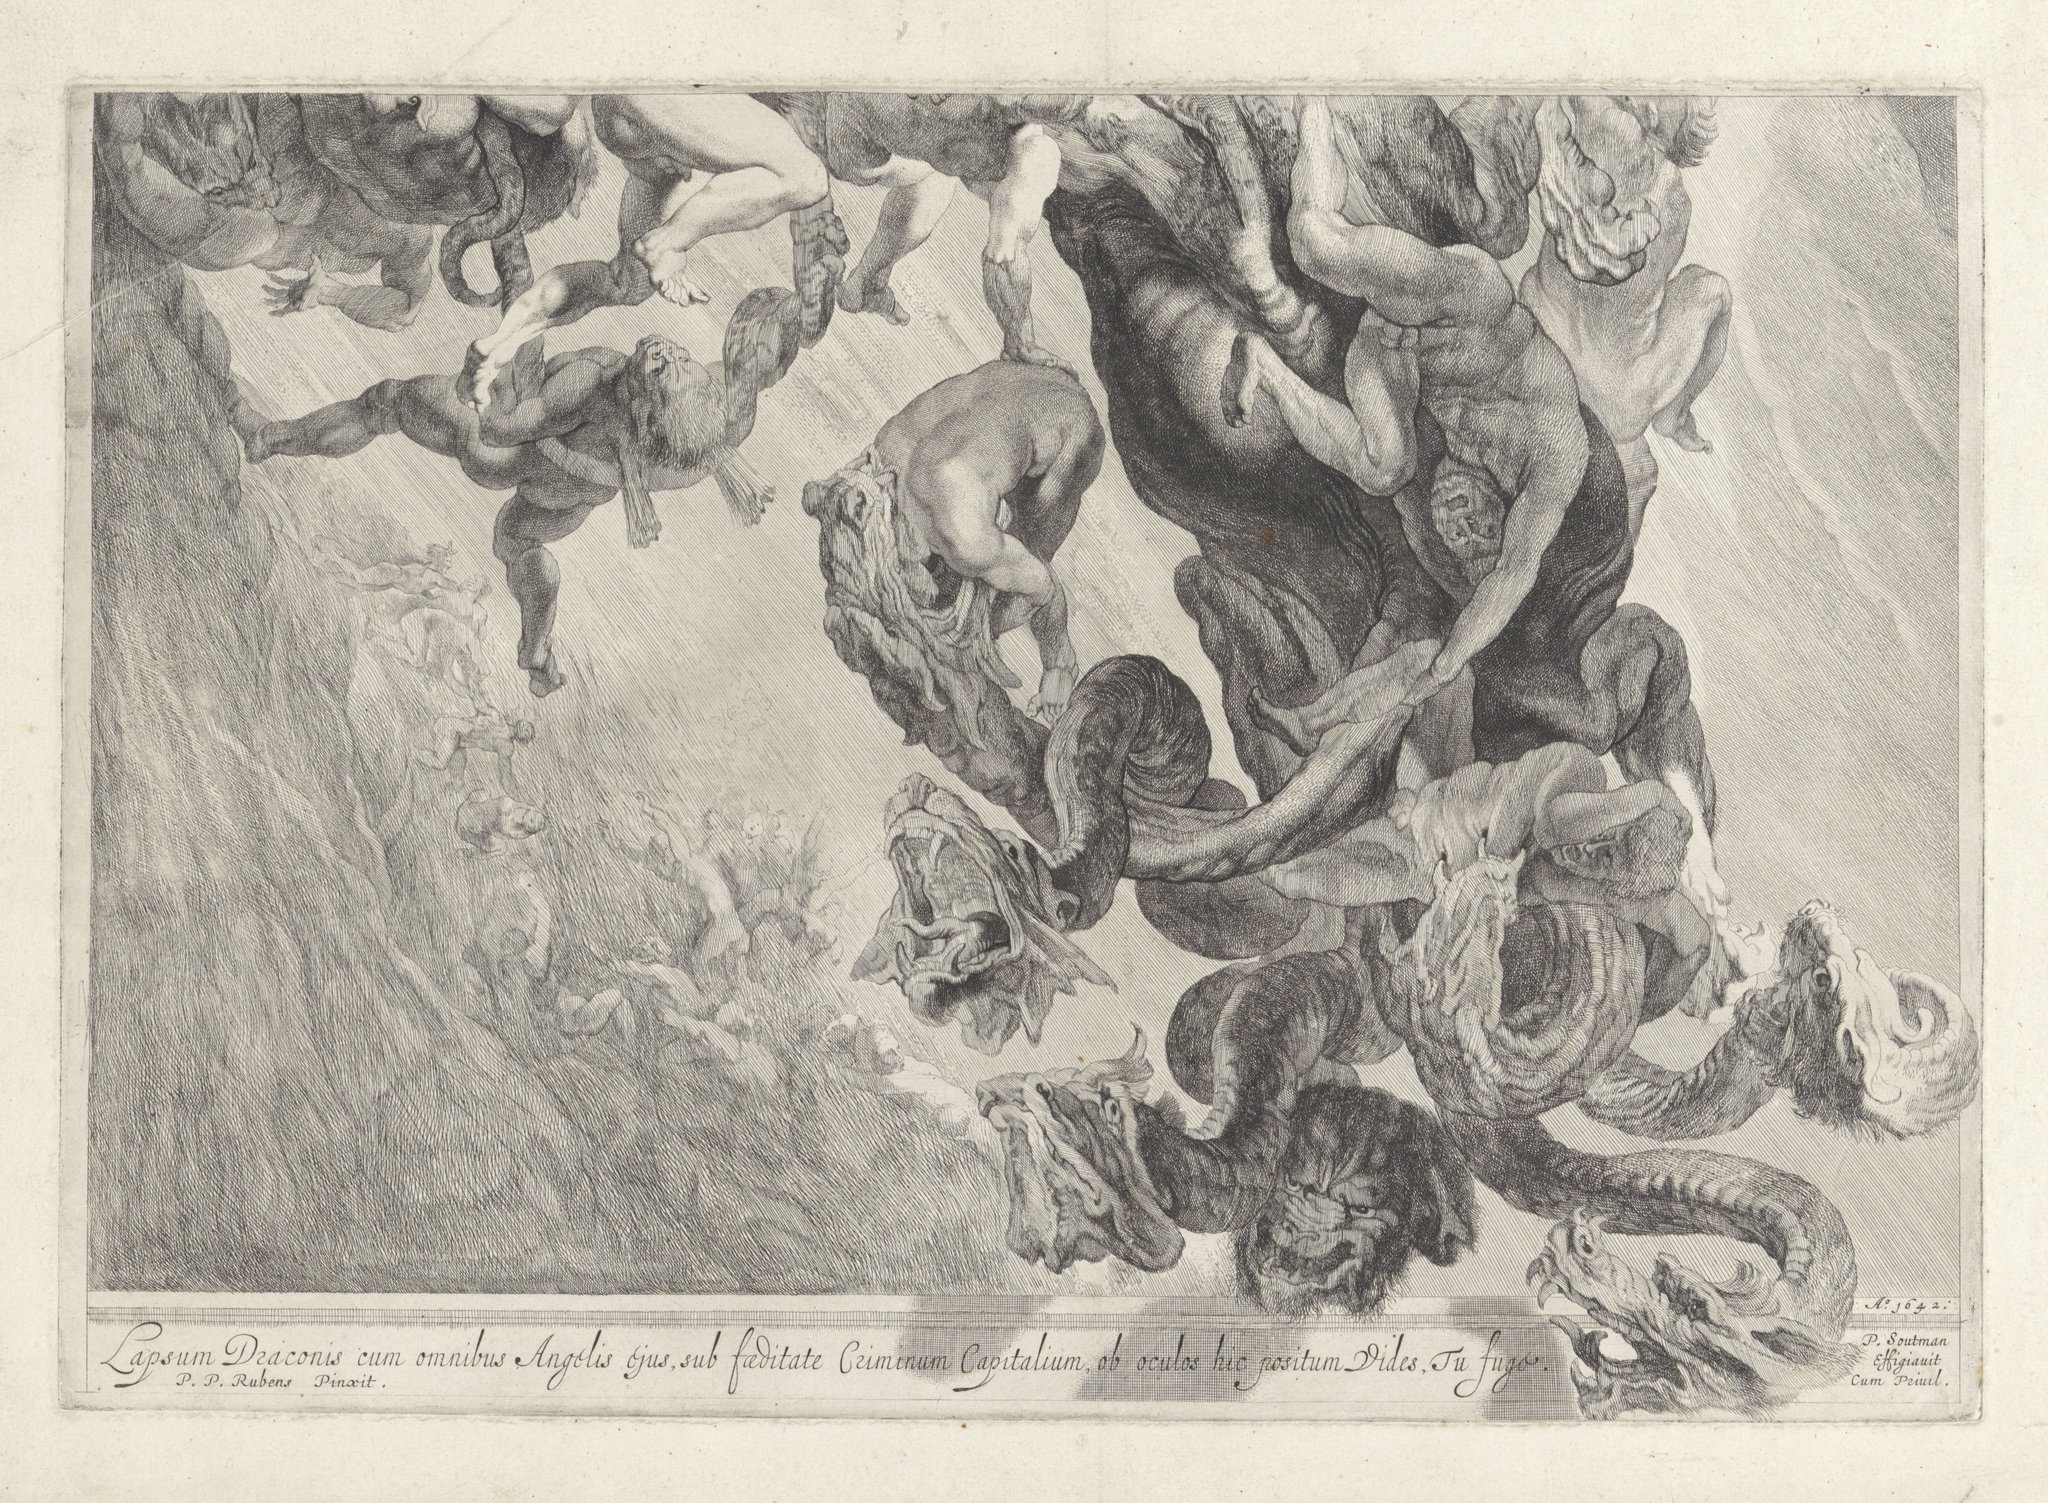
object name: print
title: De val van de verdoemden (onderste plaat)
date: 1642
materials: paper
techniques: engraving, etching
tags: the fall of the damned ~ last judgement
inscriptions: collector's mark: Lugt 240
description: Engelen gooien de verdoemden in de hel. Een veelkoppig monster slokt hen op. Onder de afbeelding een tekstregel in het Latijn. Onderste deel van een grote voorstelling bestaande uit twee delen.